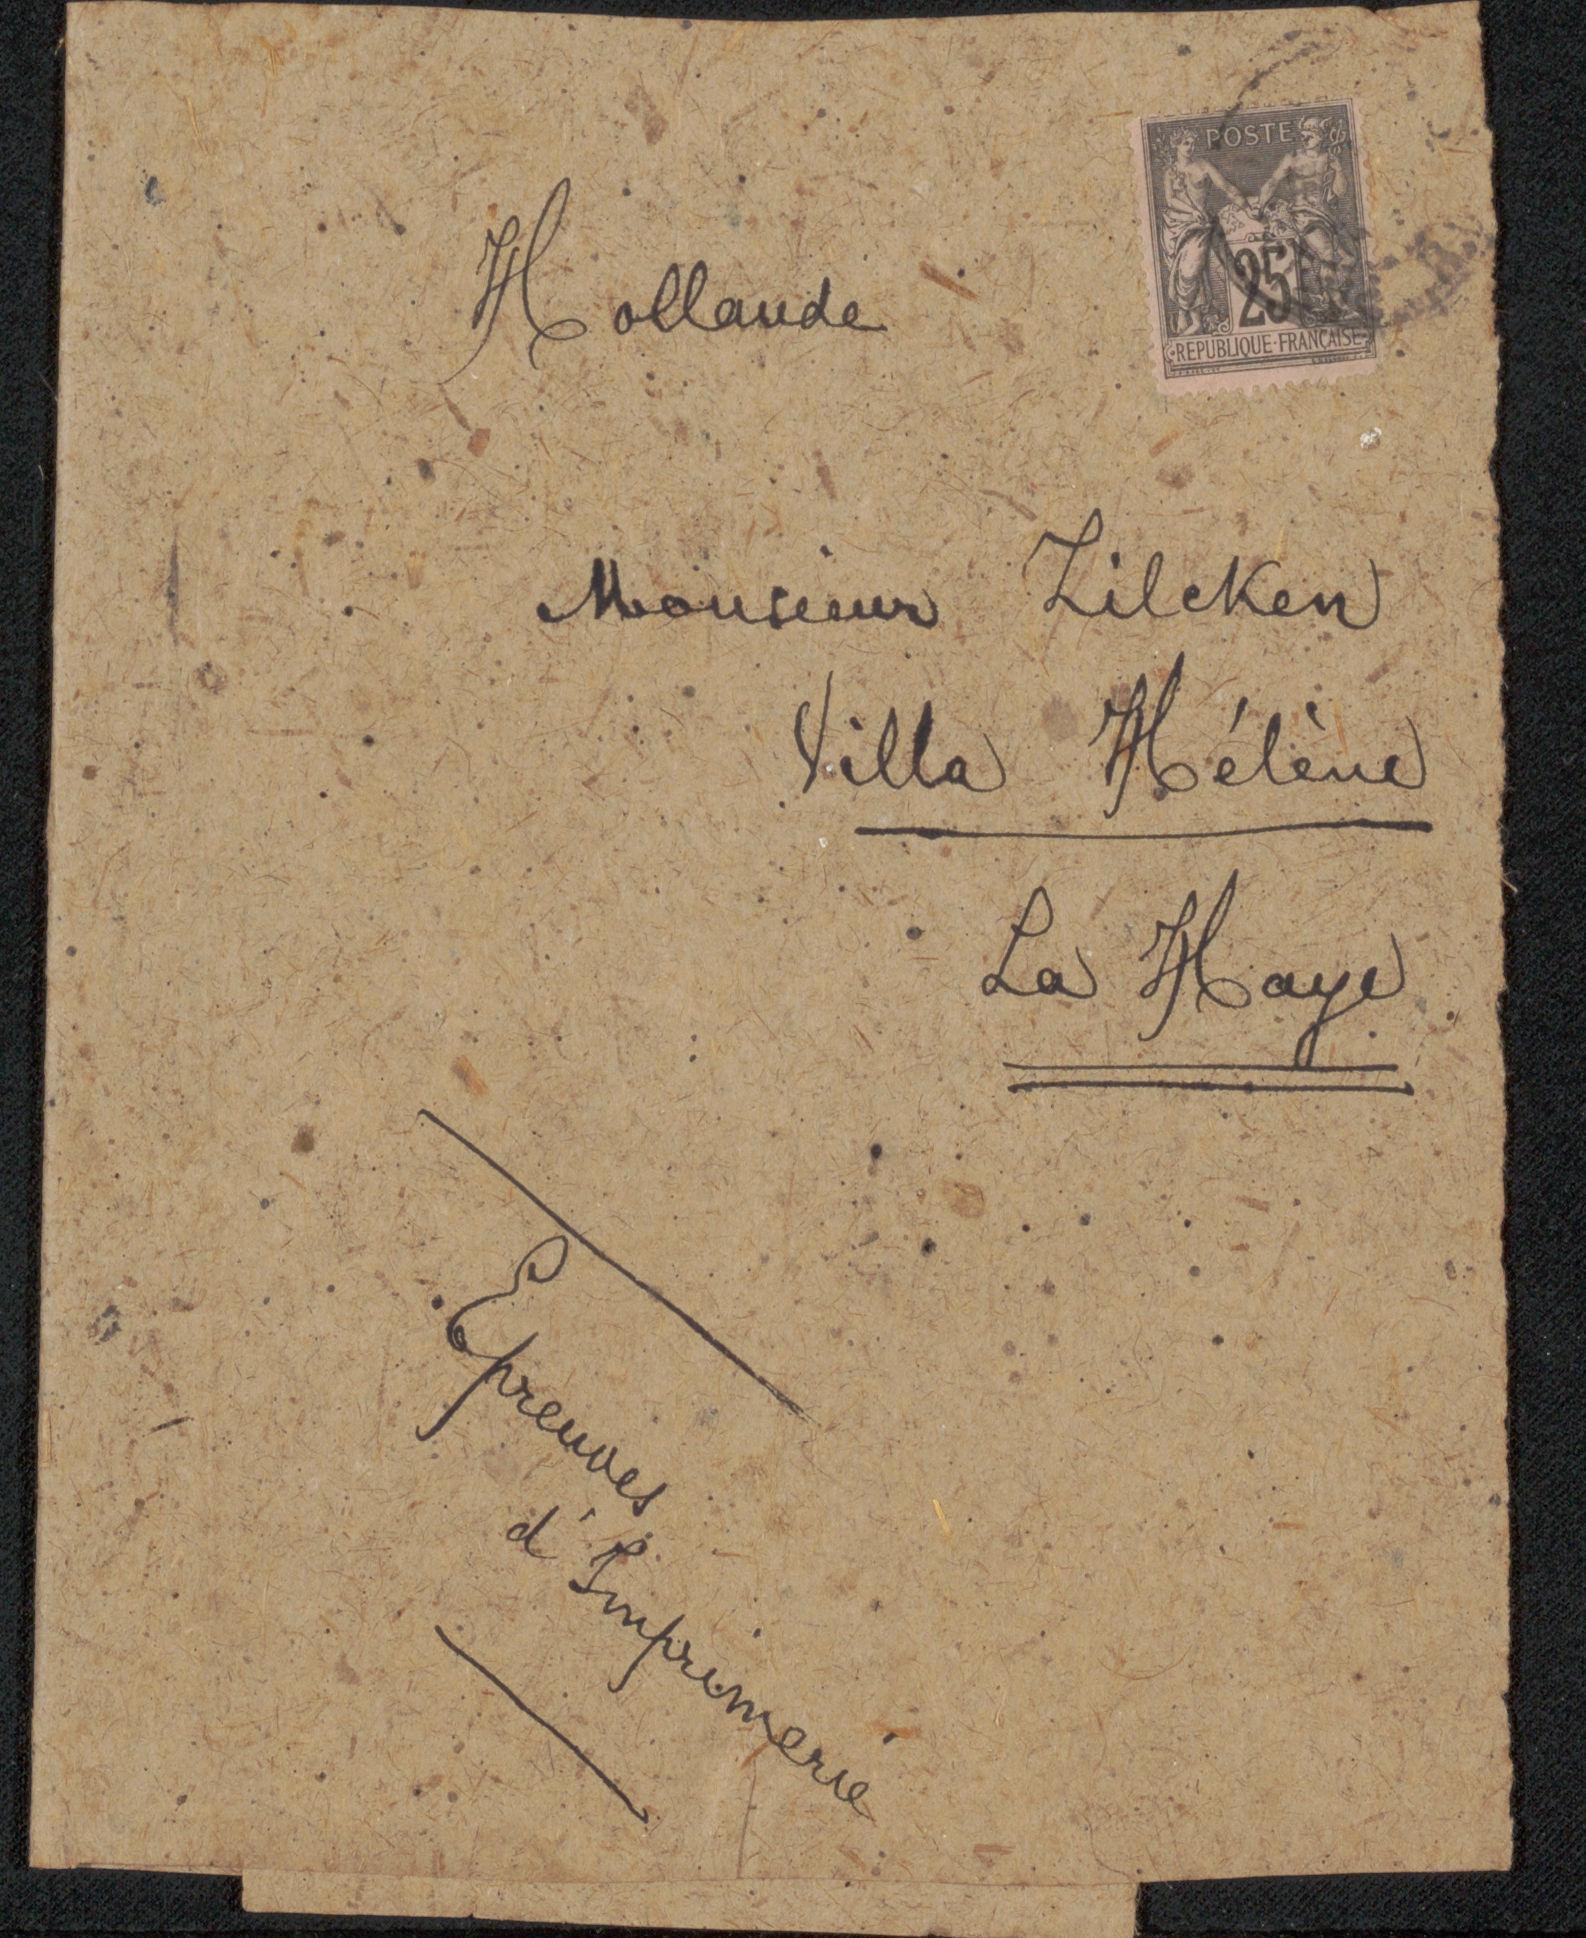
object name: tekst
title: Proefdruk voor 'Paul Verlaine. Correspondance et documents inédits relatifs à son livre "Quinze jours en Hollande"' uit archief Philip Zilcken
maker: stéphane mallarmé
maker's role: dichter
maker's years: 1842-1898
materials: ink, paper, pencil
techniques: pen, printing, writing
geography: paris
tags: jan toorop, paul verlaine, the hague, painter, draughtsman, philip zilcken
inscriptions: collector's mark: ‘RPK’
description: Tekst bevat aantekeningen van Stephane Mallarmé.